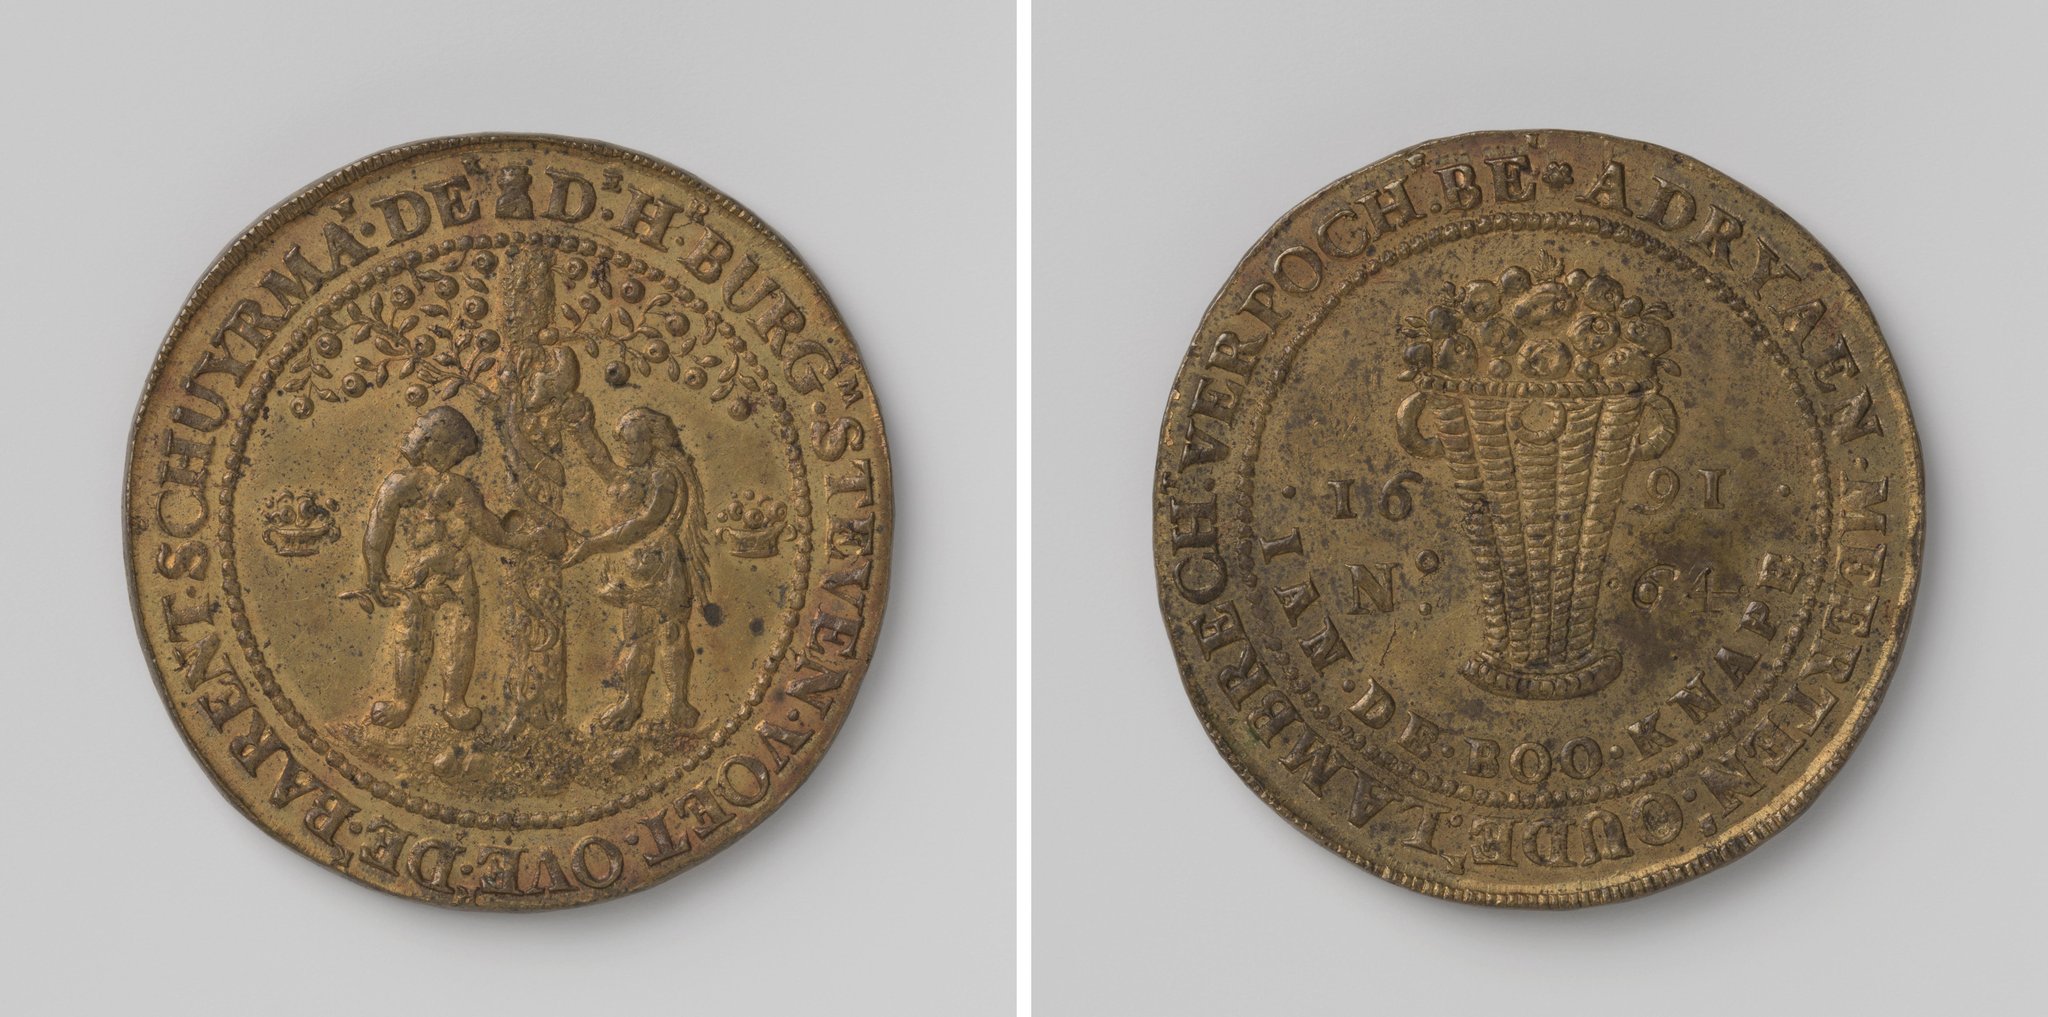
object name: medal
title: Fruiteniersgilde van Middelburg, gildepenning met no. 64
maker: Anonymous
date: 1691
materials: brass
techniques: casting, engraving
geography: middelburg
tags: middelburg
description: Messing penning. Voorzijde: Adam en Eva staande bij boom des Levens, waaromheen slang kronkelt; aan weerszijden een mandje met bloemen binnen omschrift. Keerzijde: mand gevuld met appels tussen jaartal en cijfer 64 binnen tweeregelig omschrift.